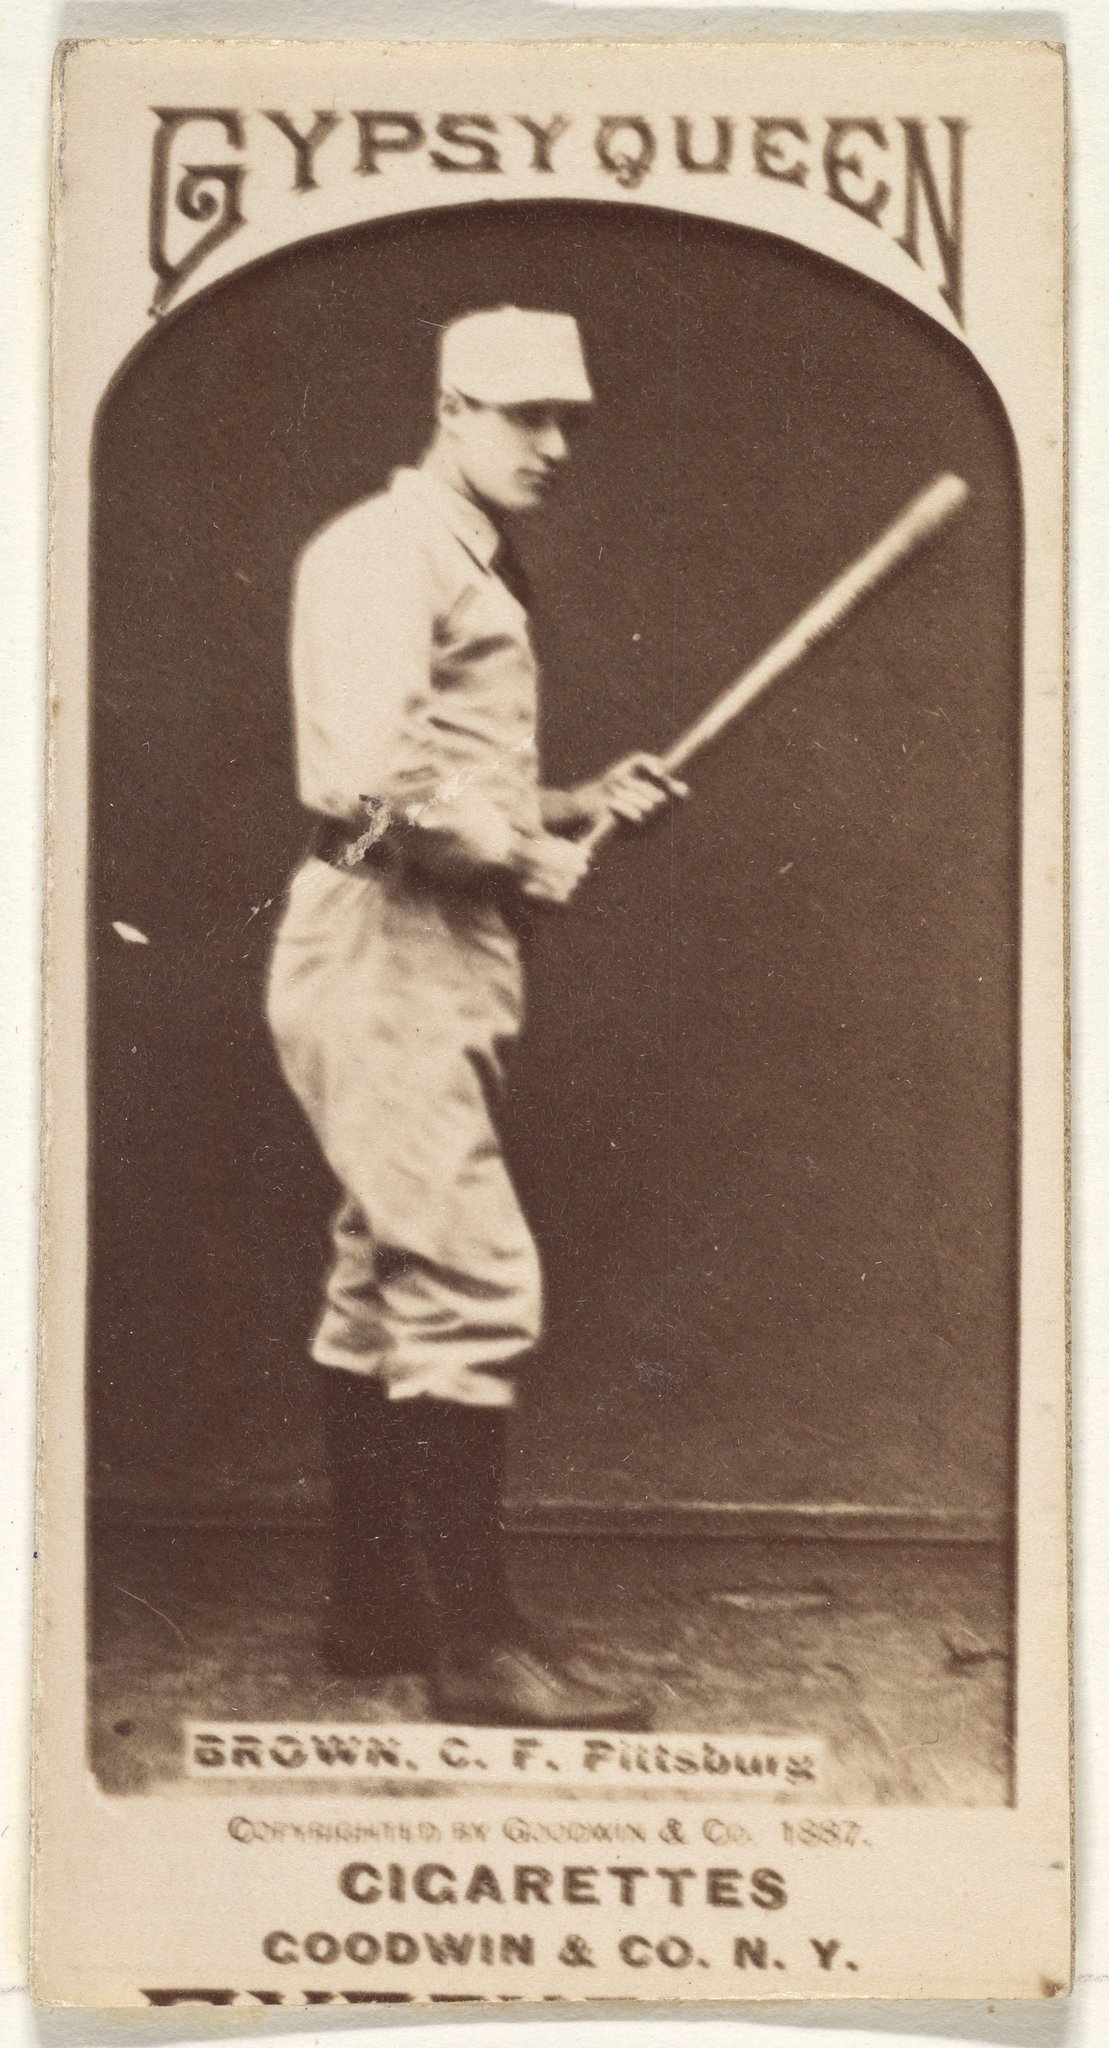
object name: baseball card, photograph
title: Thomas "Tom" Tarlton Brown, Center Field, Pittsburgh, from the Old Judge series (N172) for Old Judge and Gypsy Queen Cigarettes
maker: goodwin & company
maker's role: publisher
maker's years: 1850-1950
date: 1887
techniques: albumen silver print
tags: men,portraits,baseball,athletes